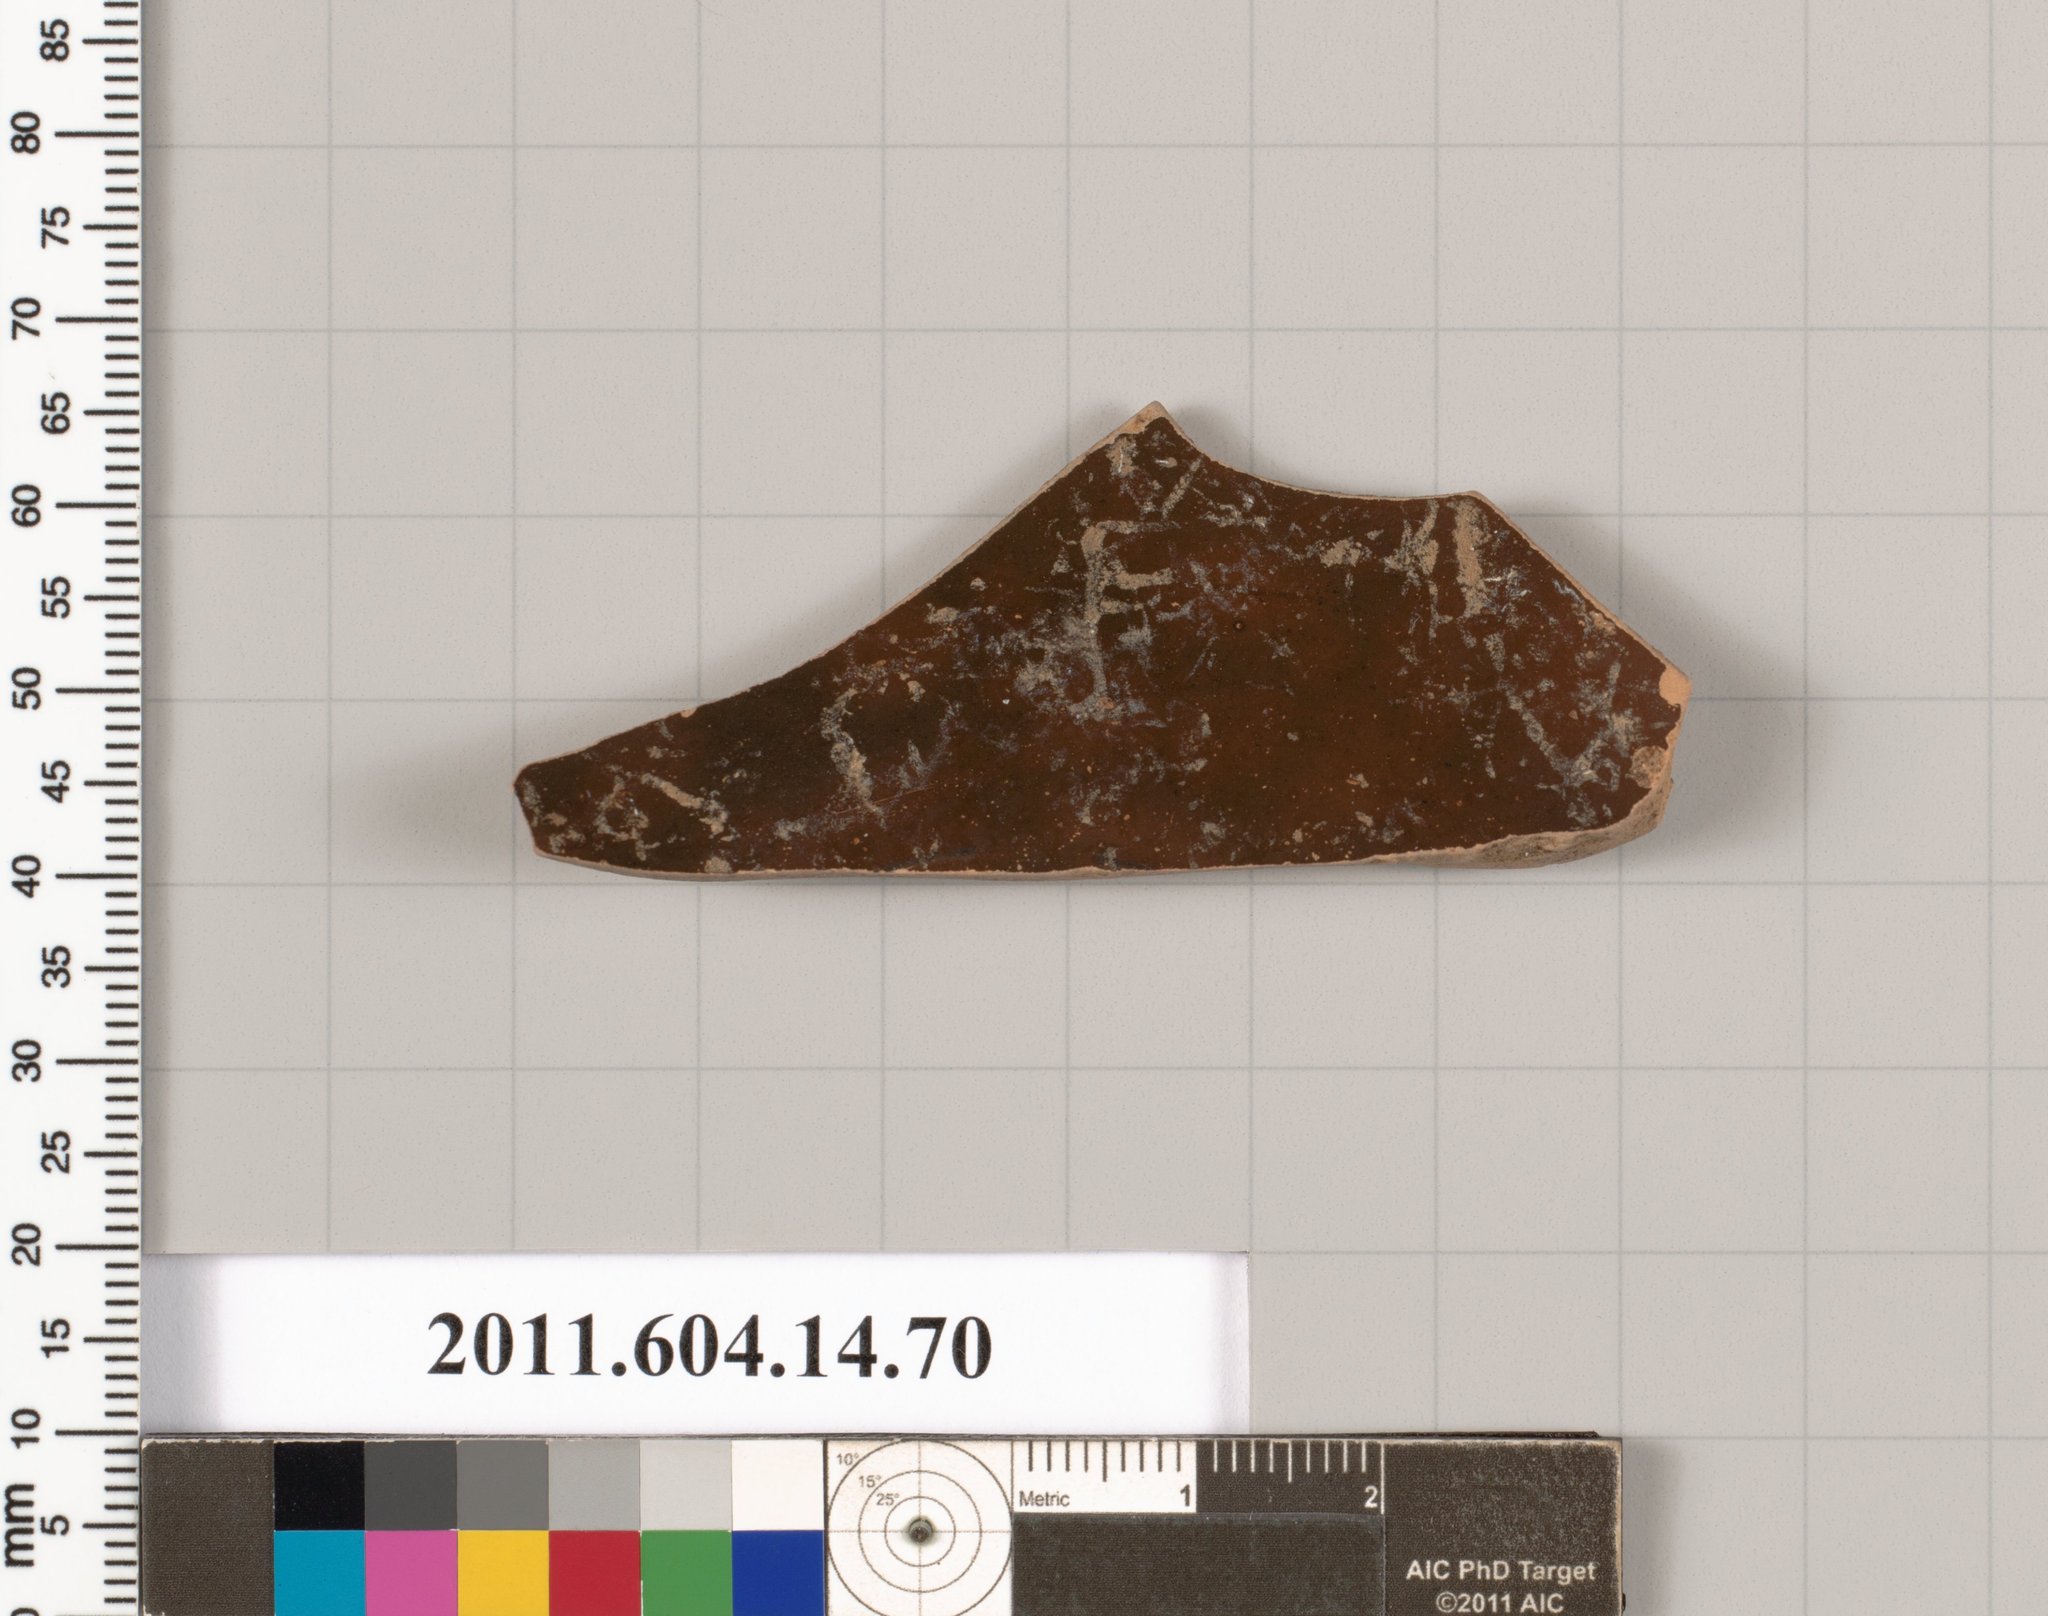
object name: kylix fragment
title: Terracotta fragment of a kylix (drinking cup)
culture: unknown fabric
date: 600-401 BCE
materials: terracotta